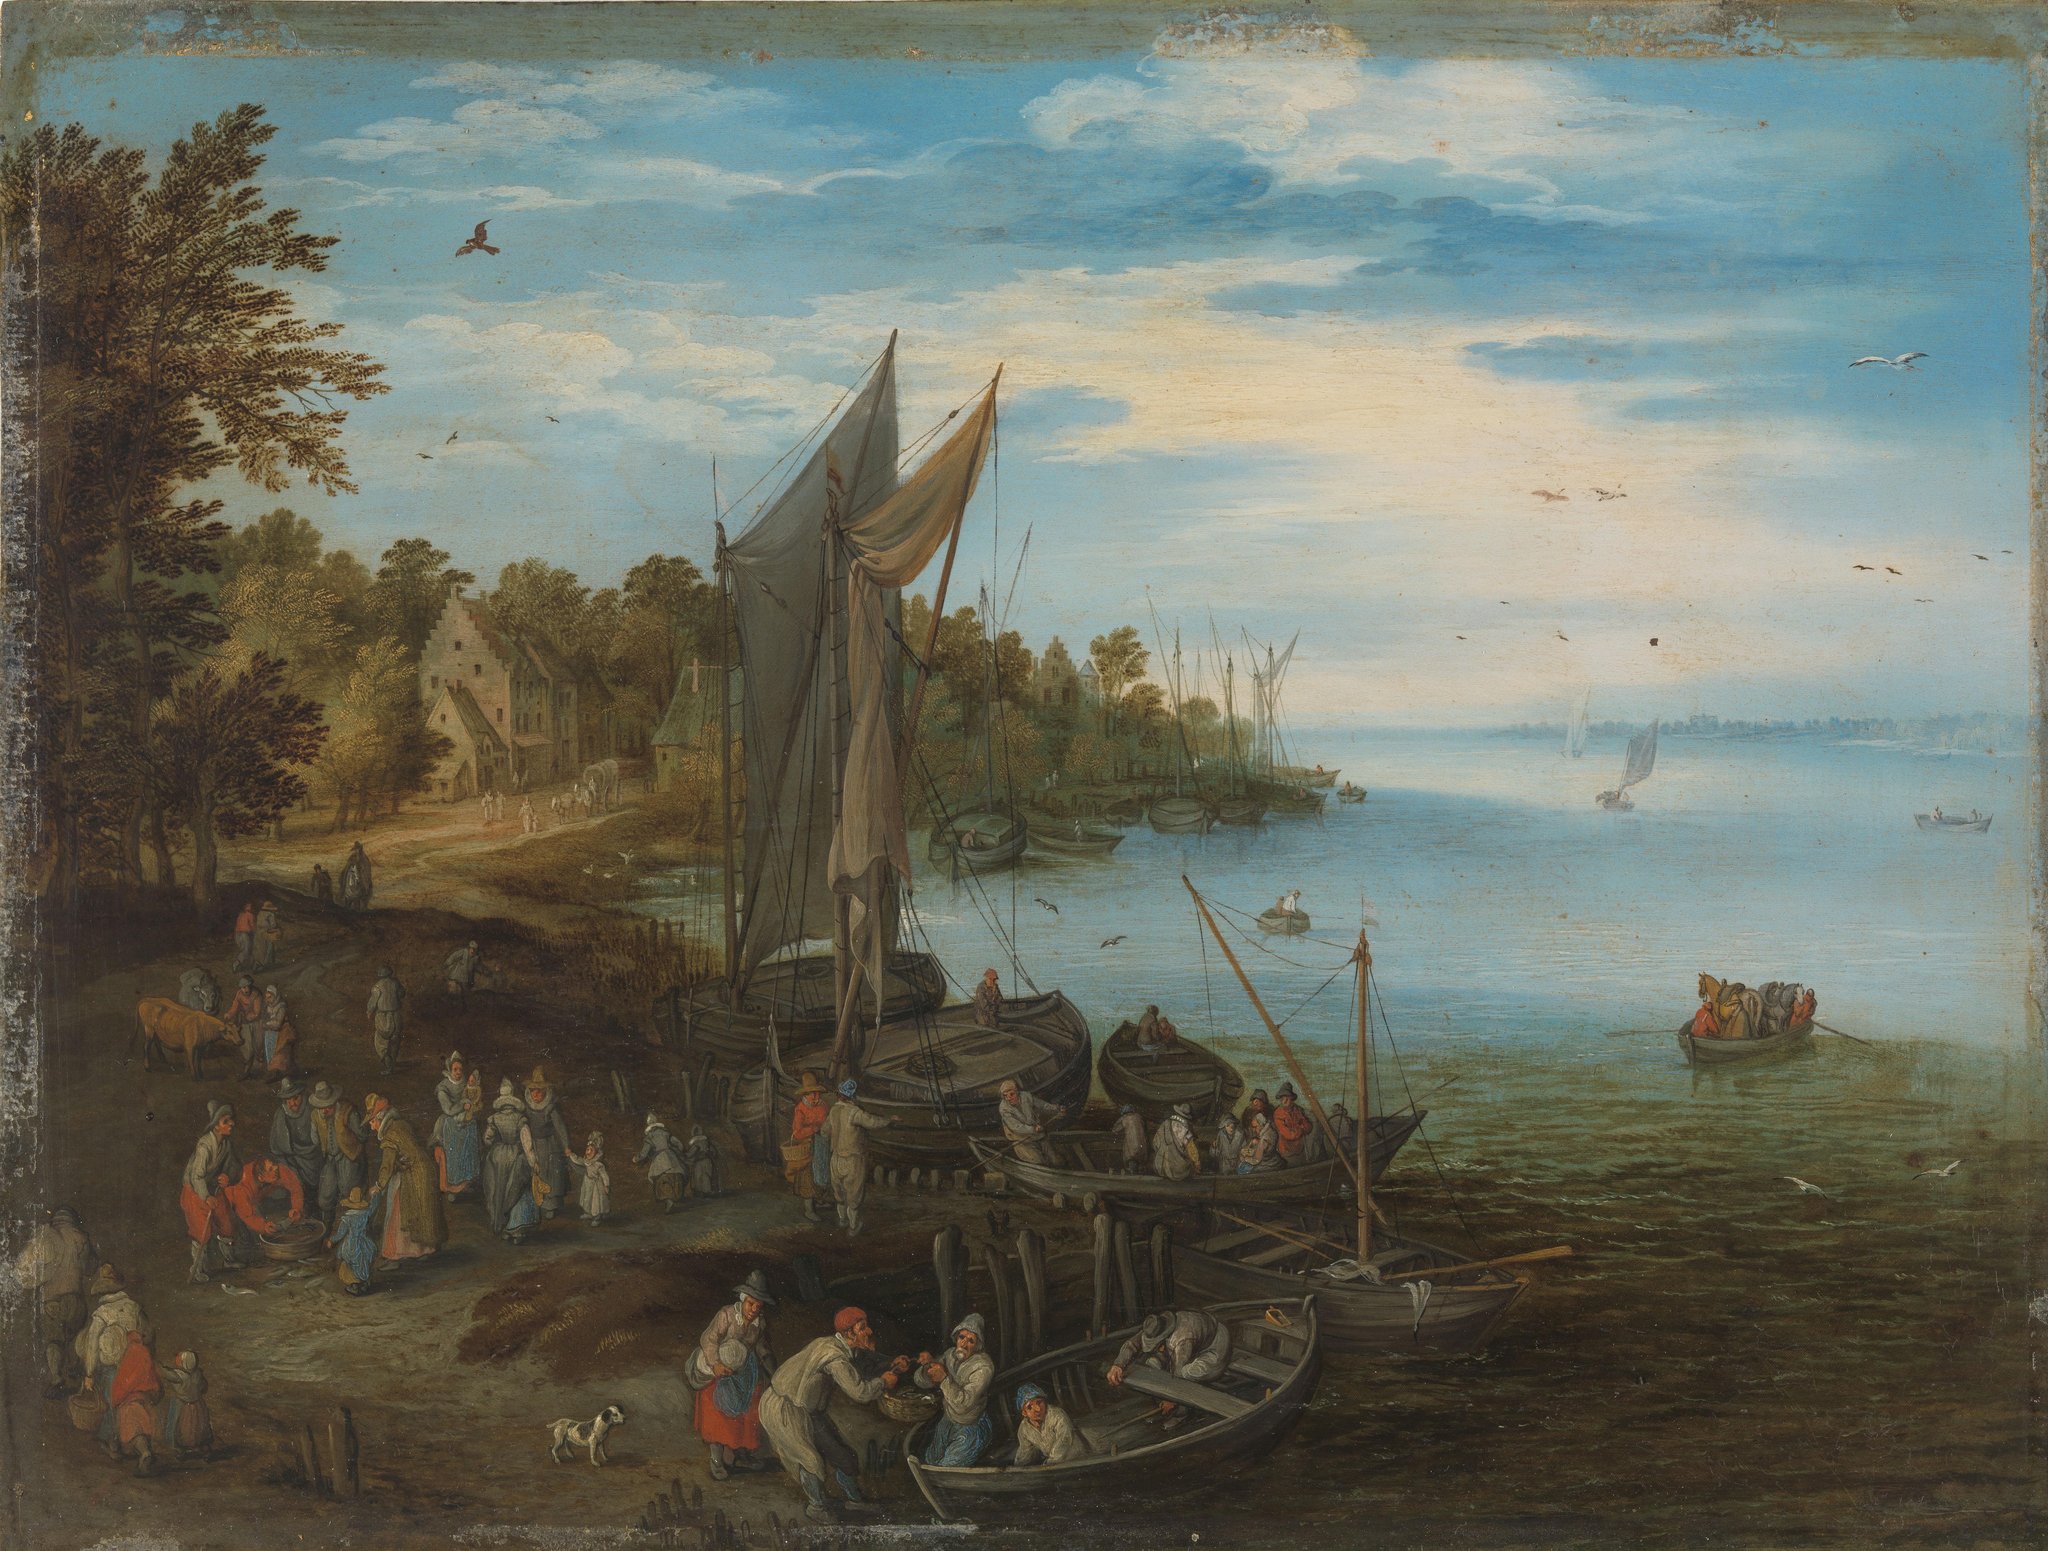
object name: painting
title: River Bank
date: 1600-1650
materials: copper, oil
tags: sailing-ship, sailing-boat, river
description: Rivierlandschap. Aan de oever van een water worden allerlei personen in en uit bootjes geladen.